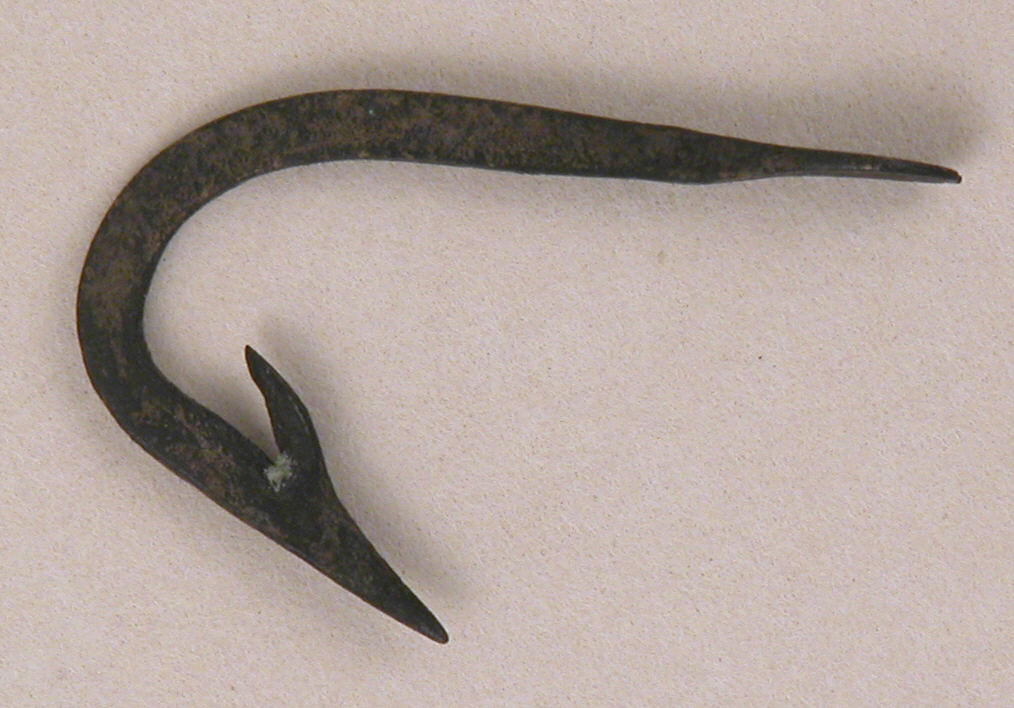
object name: fish hook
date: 401-800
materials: bronze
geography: palestine